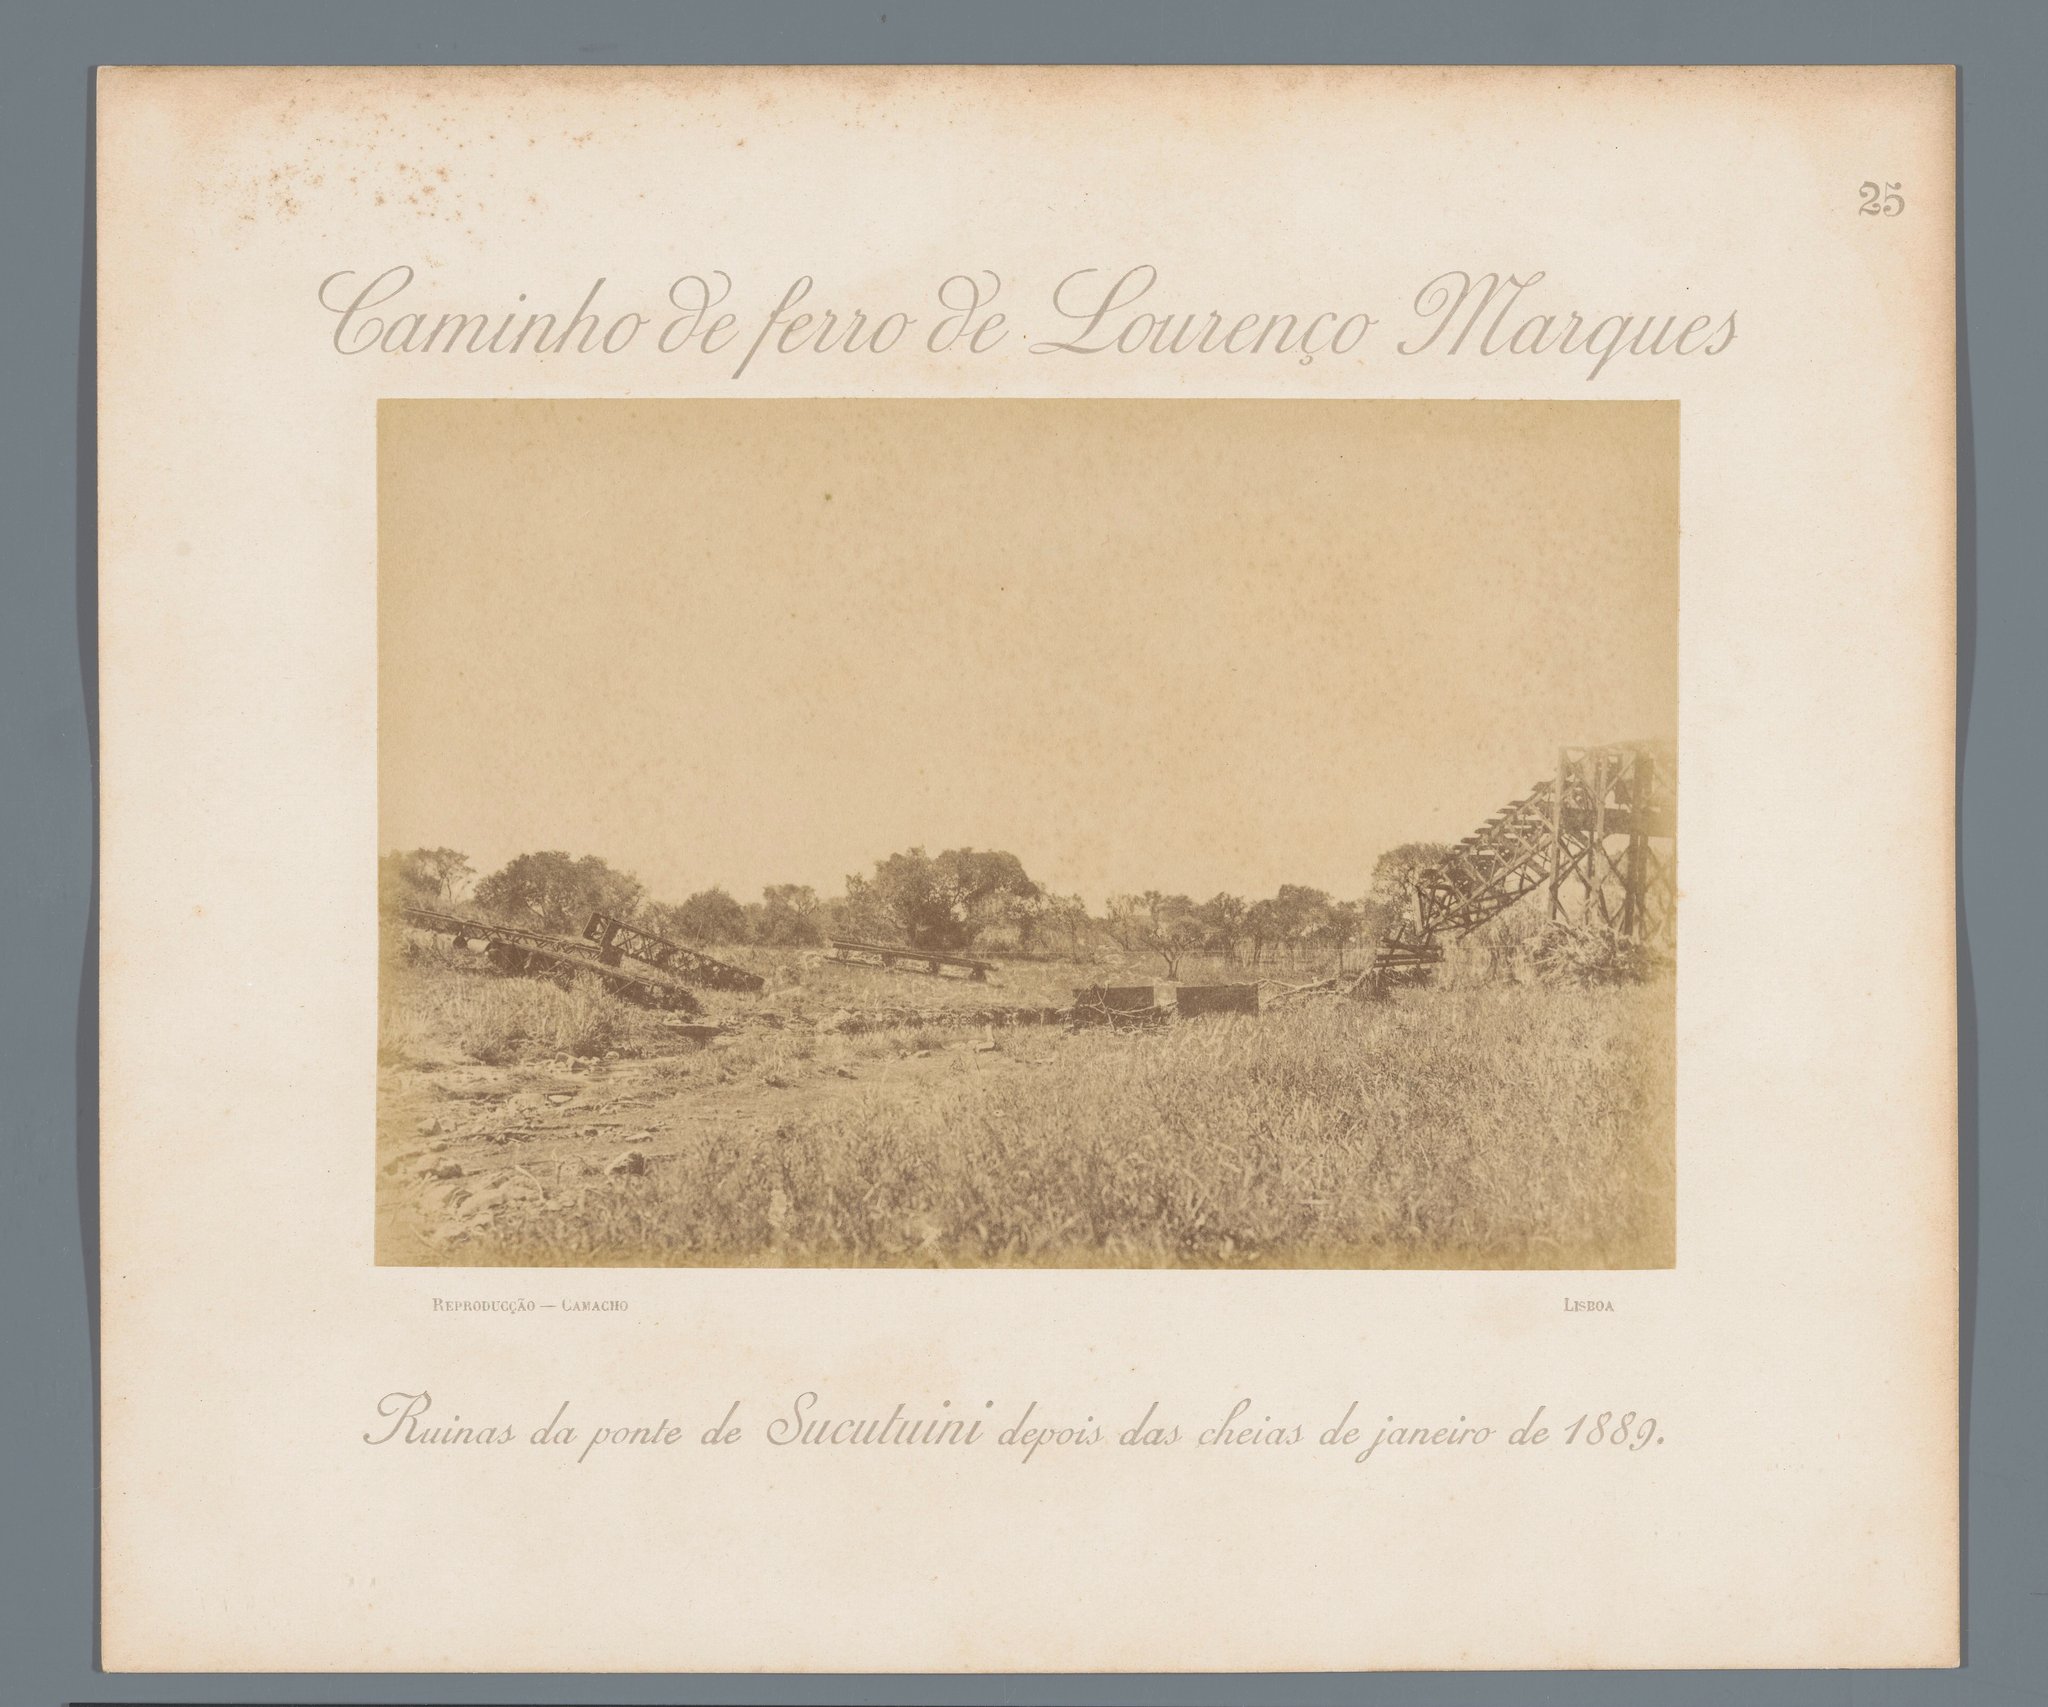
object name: page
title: Caminho de ferro de Lourenço Marques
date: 1886-1895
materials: photographic support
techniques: albumen print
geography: lisbon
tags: bridges by construction, railway, train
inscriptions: number: ‘25’